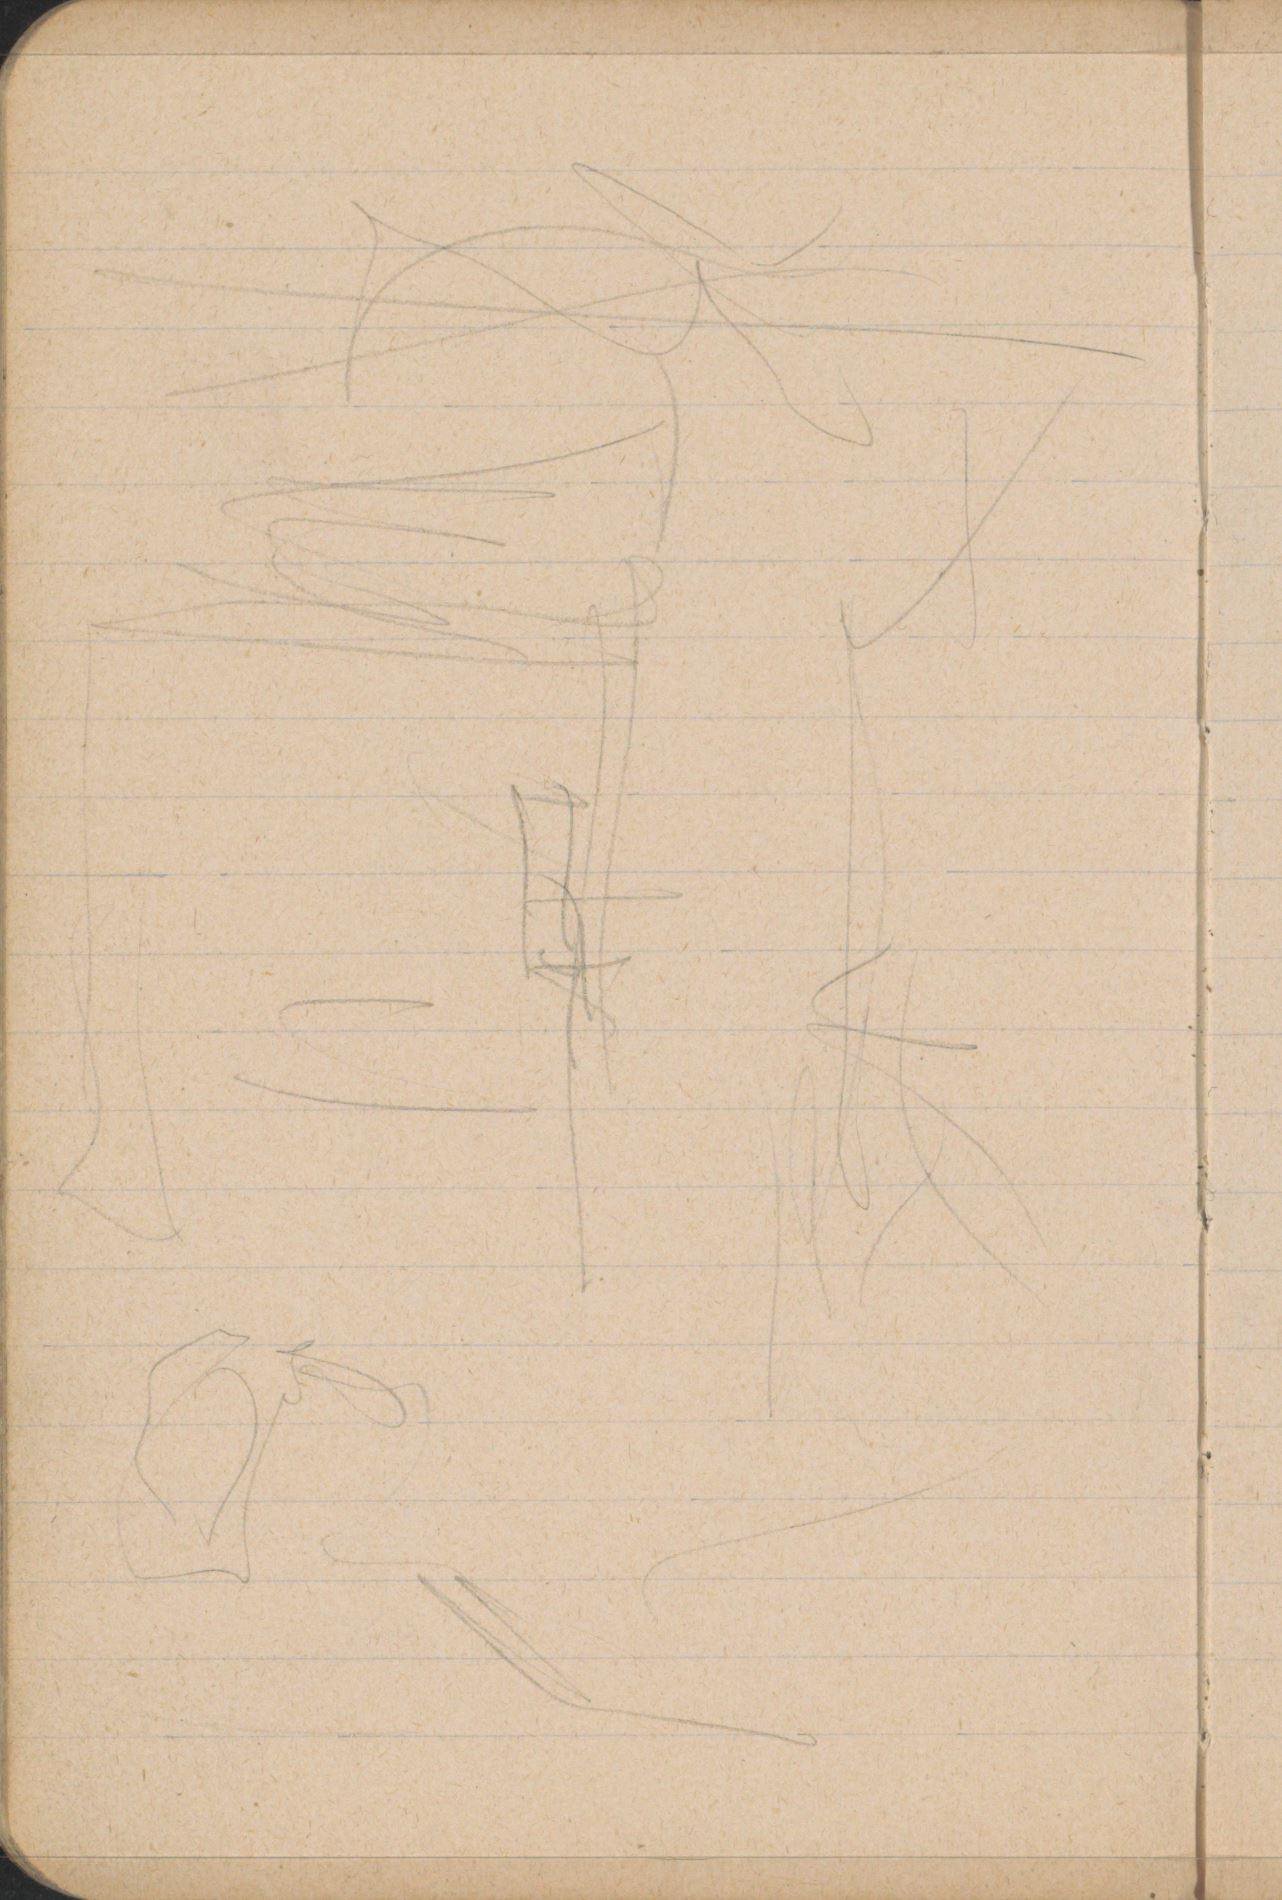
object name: sketchbook leaf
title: Gezicht in Amsterdam met een figuur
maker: george hendrik breitner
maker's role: draughtsman, painter, print maker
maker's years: 1857-1923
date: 1903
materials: pencil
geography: amsterdam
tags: city-view, and landscape with man-made constructions, adult man, civic architecture; edifices; dwellings, amsterdam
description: Pagina 21 uit een schetsboek met 32 bladen.